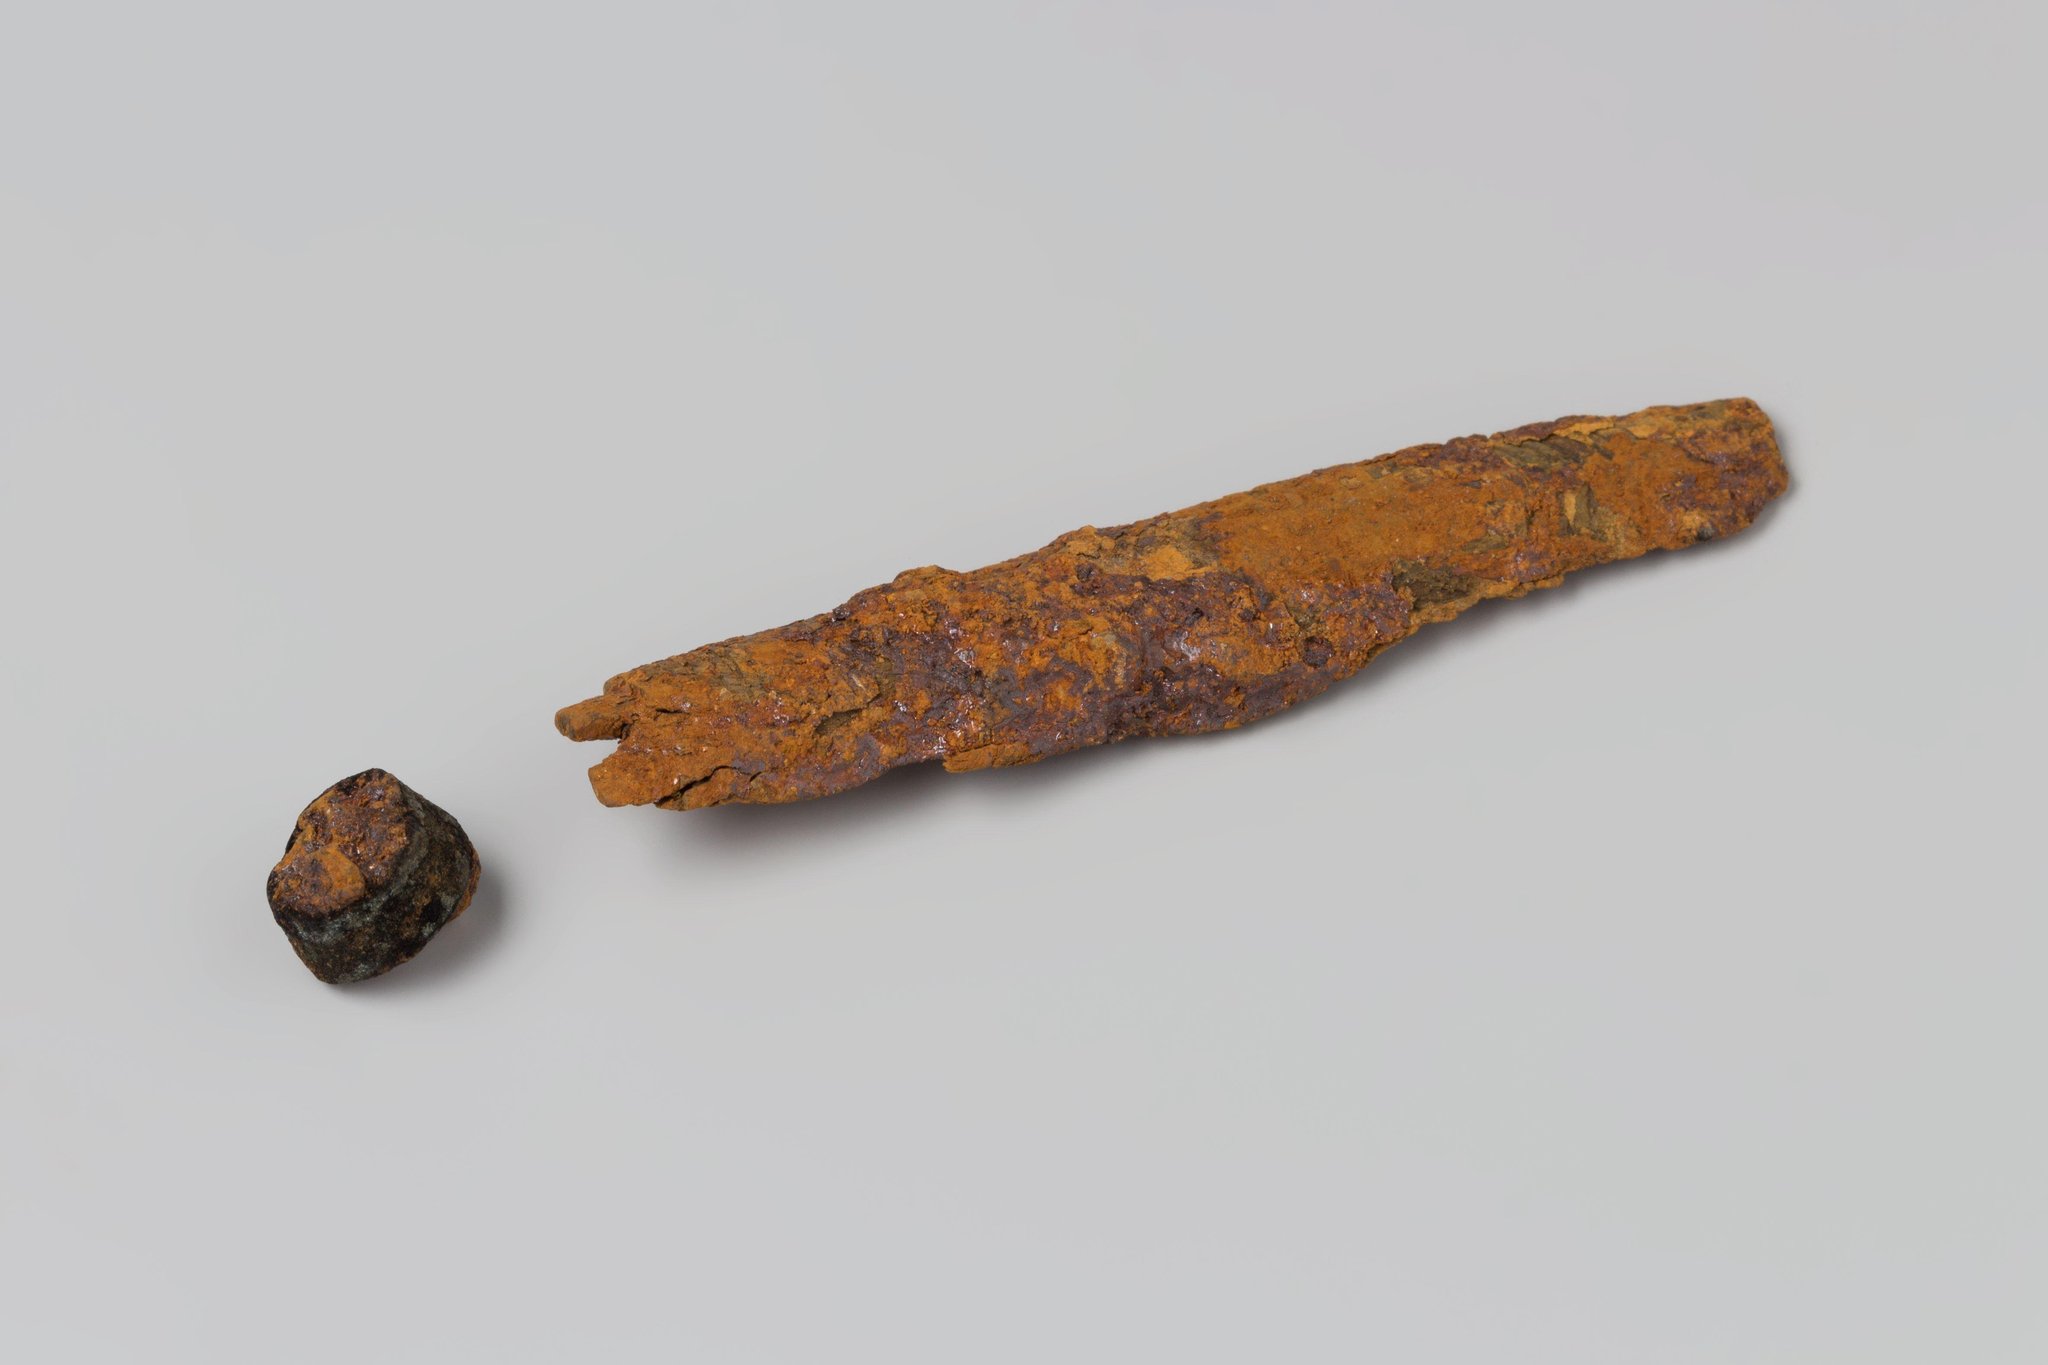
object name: fragment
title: Fragment messenheft en koper uit het wrak van de Oost-Indiëvaarder Hollandia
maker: Anonymous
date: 1700-1743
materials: copper, wood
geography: netherlands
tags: verenigde oostindische compagnie, hollandia (schip), annet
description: Knife, handle, cylindrical: tapering; fragm, id. NG 1979-403H, ferrule, id. NG 1980-27H426.